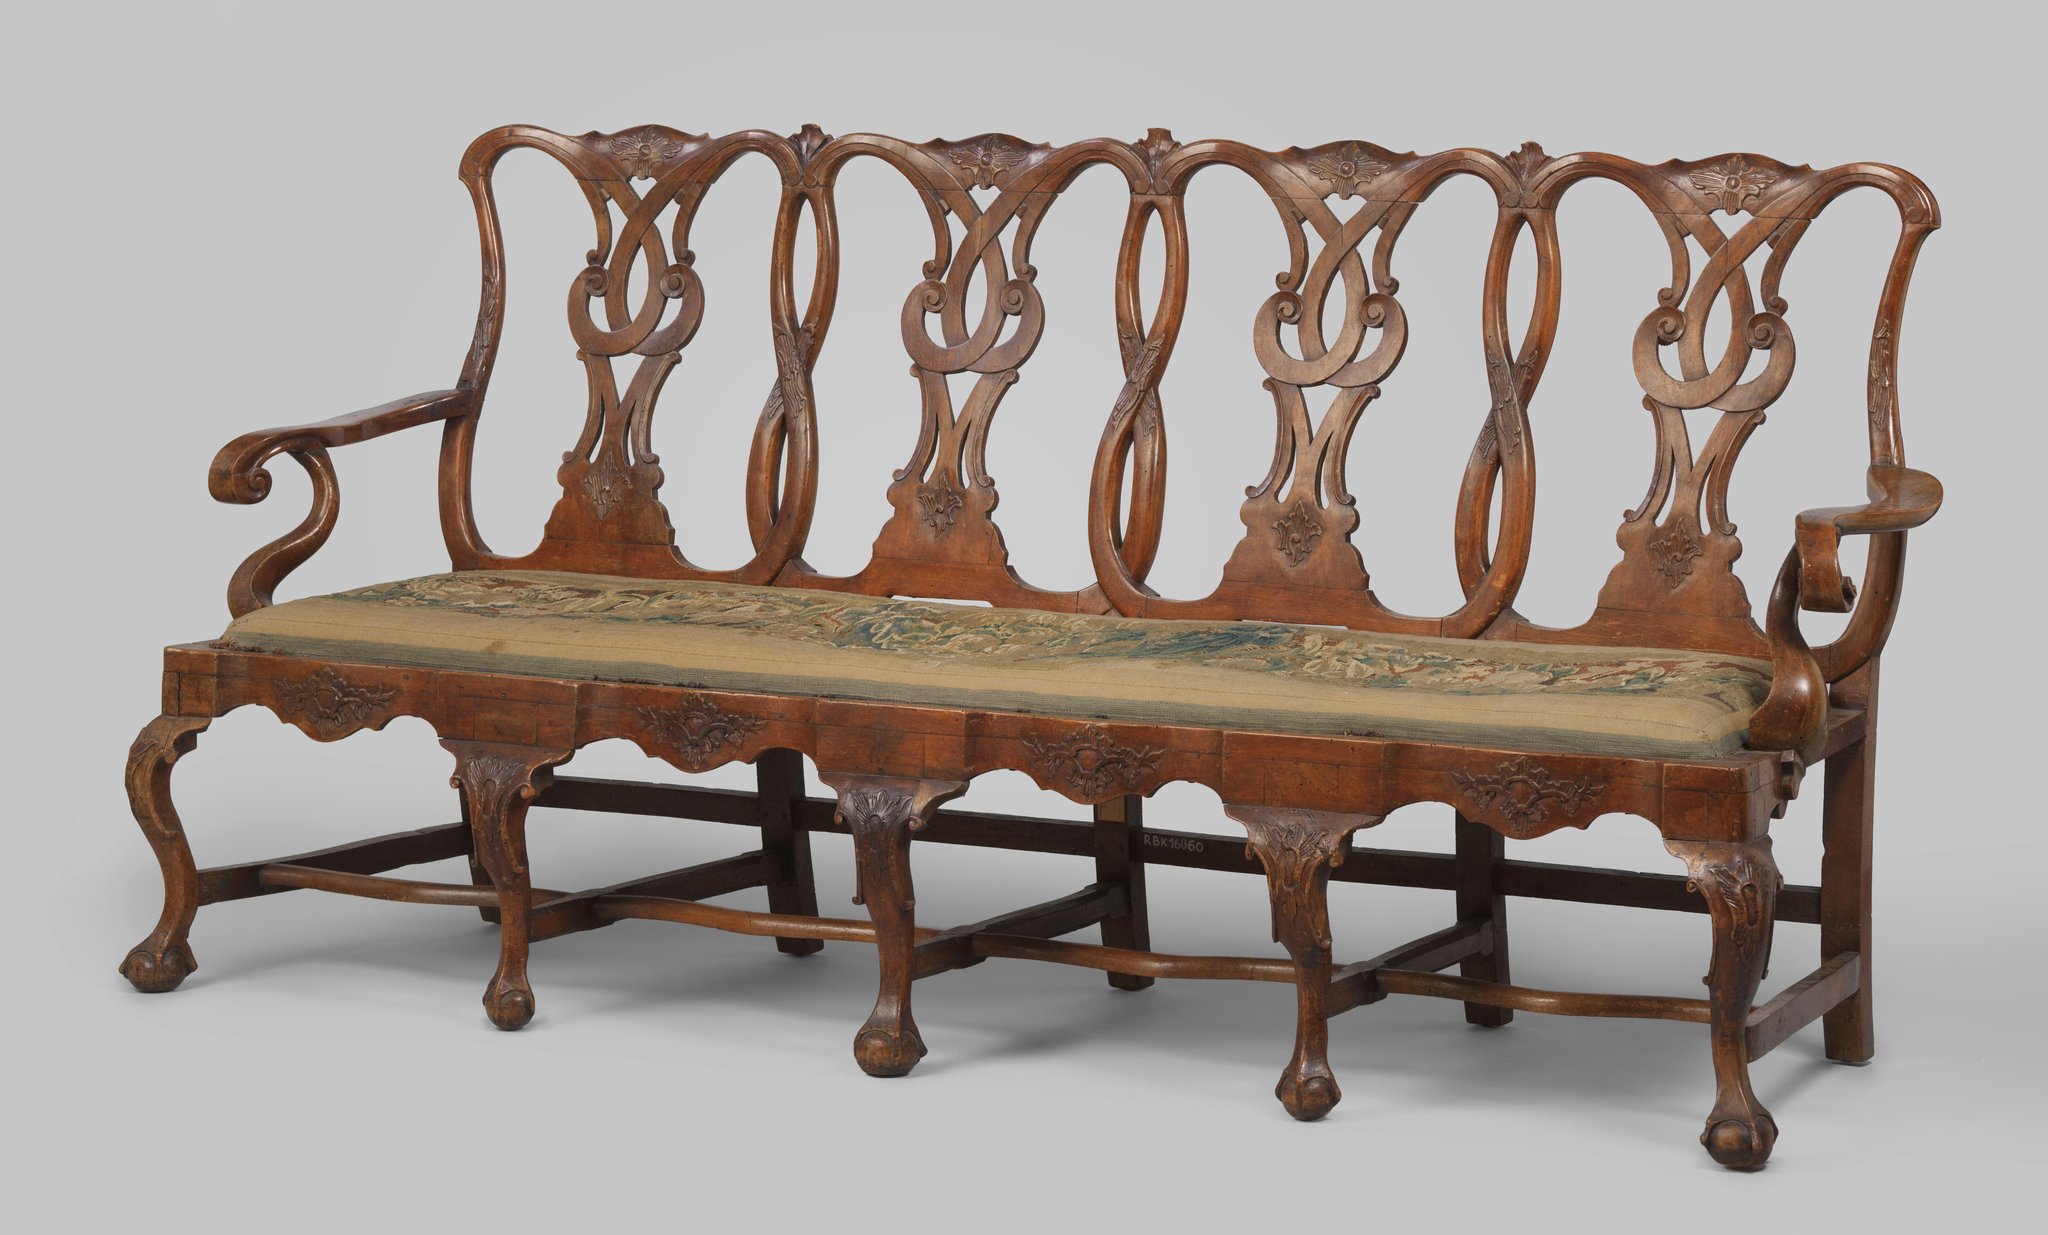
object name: sofa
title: Canapé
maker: Anonymous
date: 1700-1800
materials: textile, wood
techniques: tapestry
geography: germany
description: Canapé van notenhout. De vijf vierkante achterpoten zijn achterwaarts en de voorste hoekpoten overhoeks geplaatst; de vijf voorpoten met bal en klauw zijn S-vormig. De poten en de gegolfde voorzitregel tonen bladwerk. Het kruisraam heeft een gegolfde dwarsregel. De platte gebogen armleggers eindigen in voluten en rusten op gedrongen S-vormige stutten. De rug bestaat uit vier opengewerkte verbindingsstukken in vlechtbandmotief, gescheiden door gevlochten stijlen, versierd met bladwerk. Zitting met tapisserie.